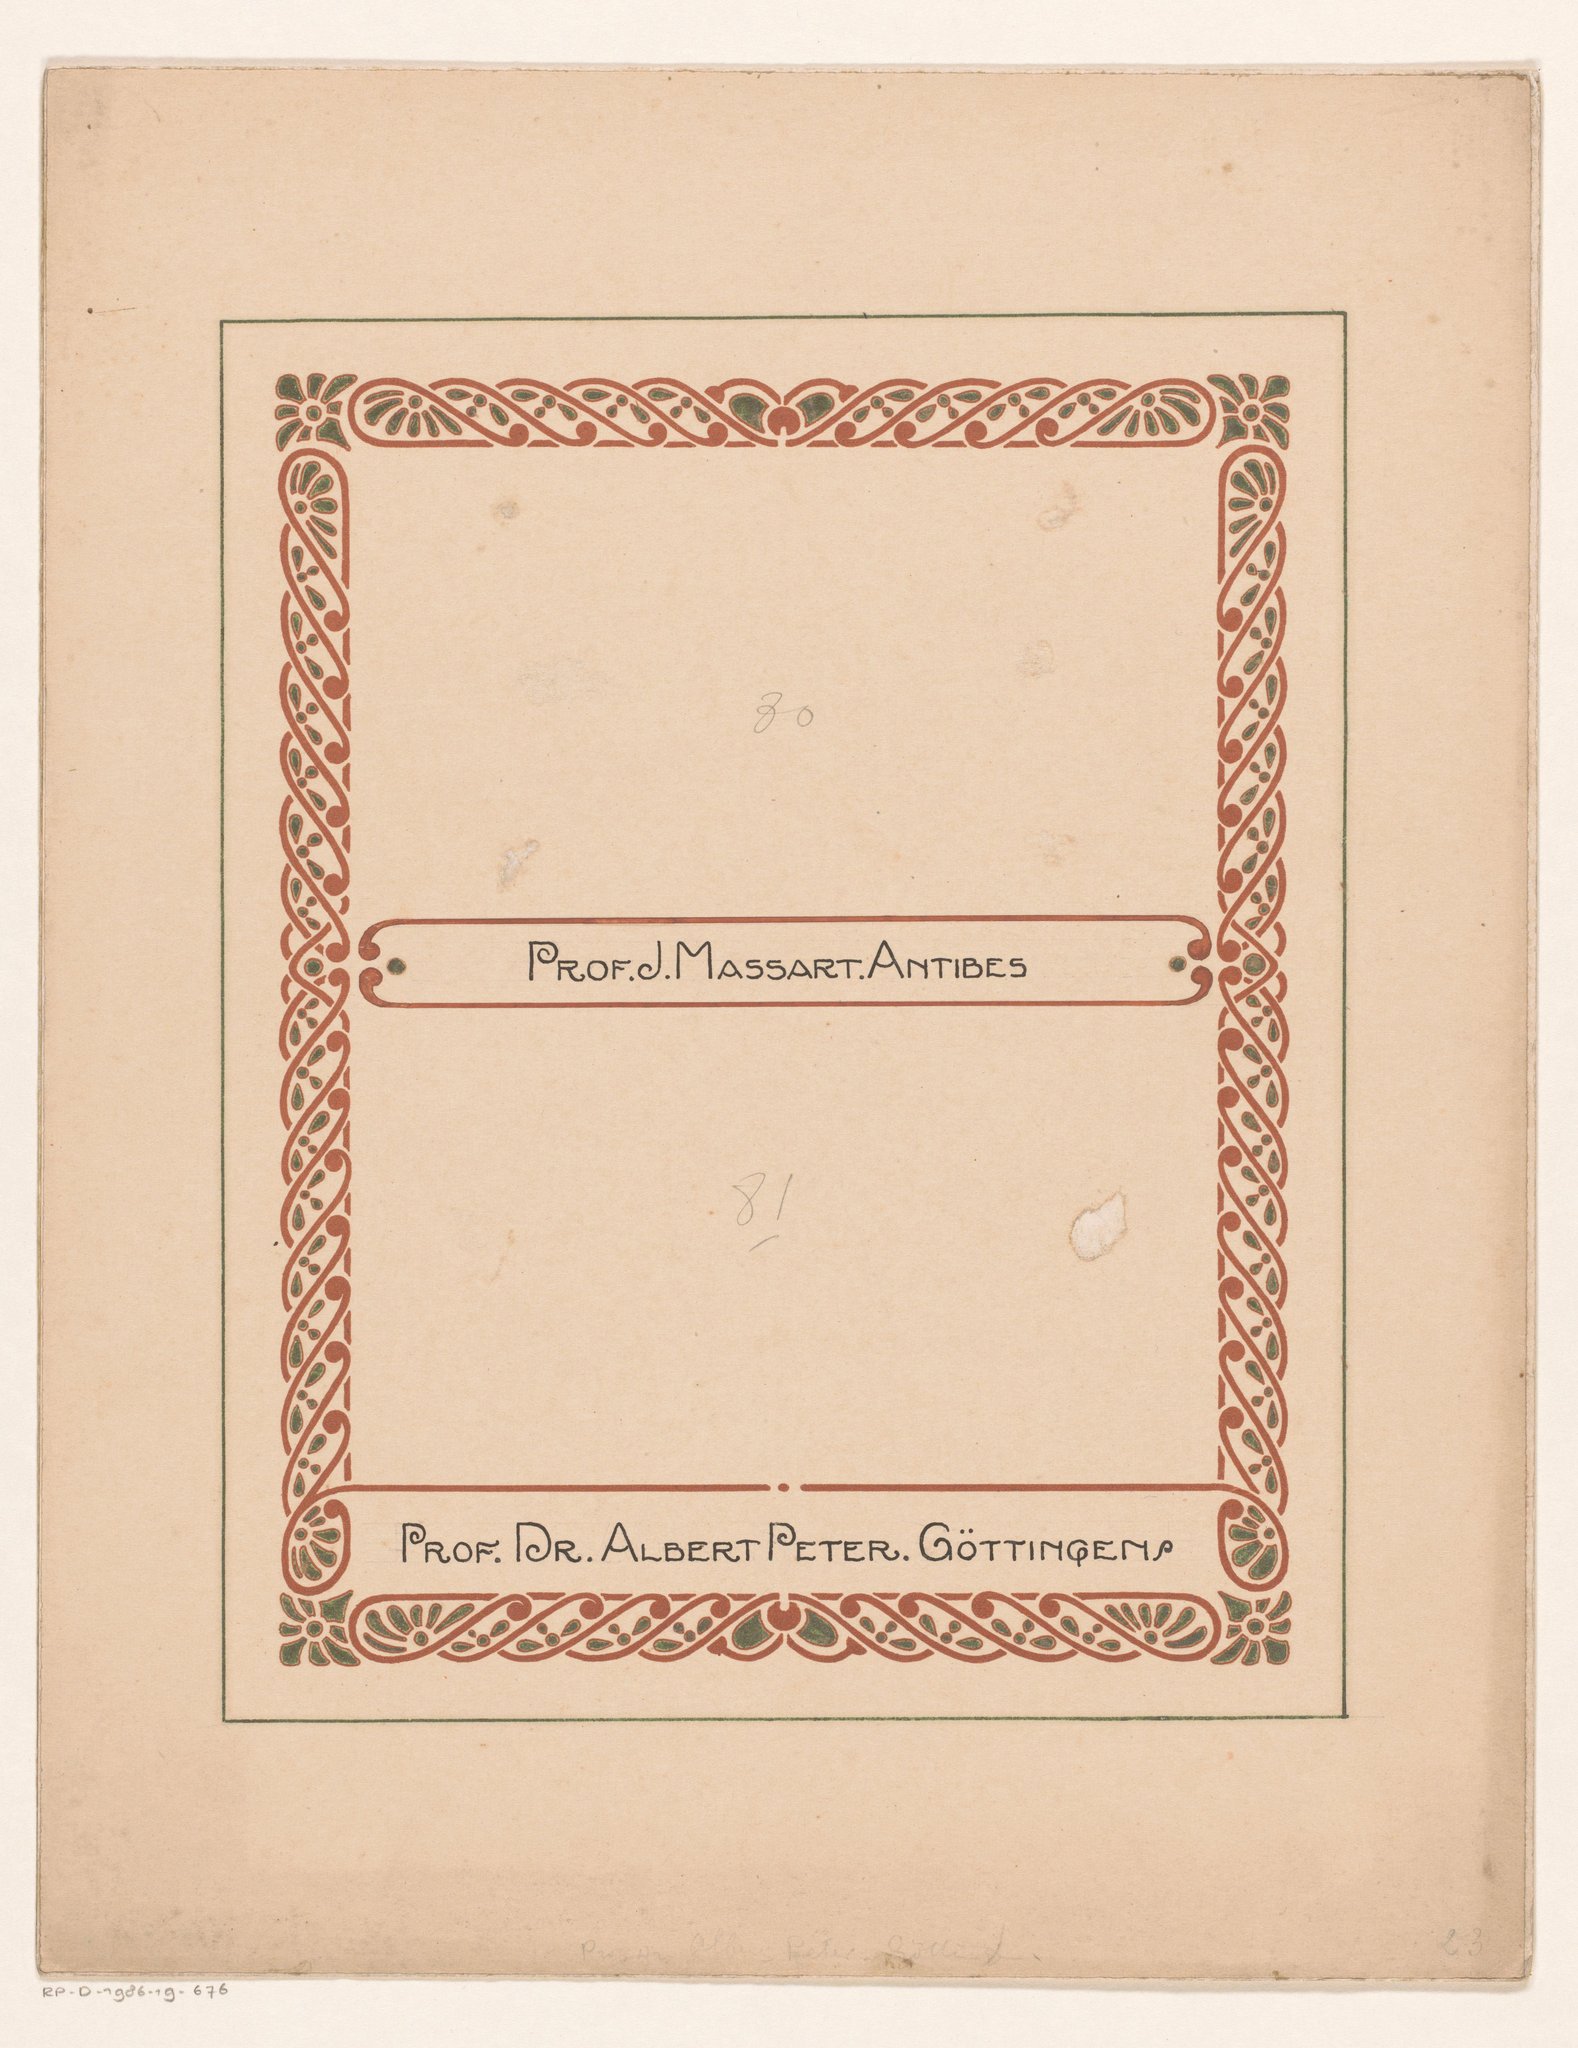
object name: print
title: Albumblad voor een album voor Prof. Hugo de Vries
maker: reinier willem petrus de vries (1874-1953)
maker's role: draughtsman, print maker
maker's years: 1874-1953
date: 1918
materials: paint, ink, paper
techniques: brush, lithograph, pen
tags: haarlem, hugo de vries, flowers ~ ornament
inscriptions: collector's mark: ‘R:MVS.’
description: Rechthoekig kader met bloemornamenten met daarin twee vakken voor portretten met onder elk vak de naam van de geportretteerde.